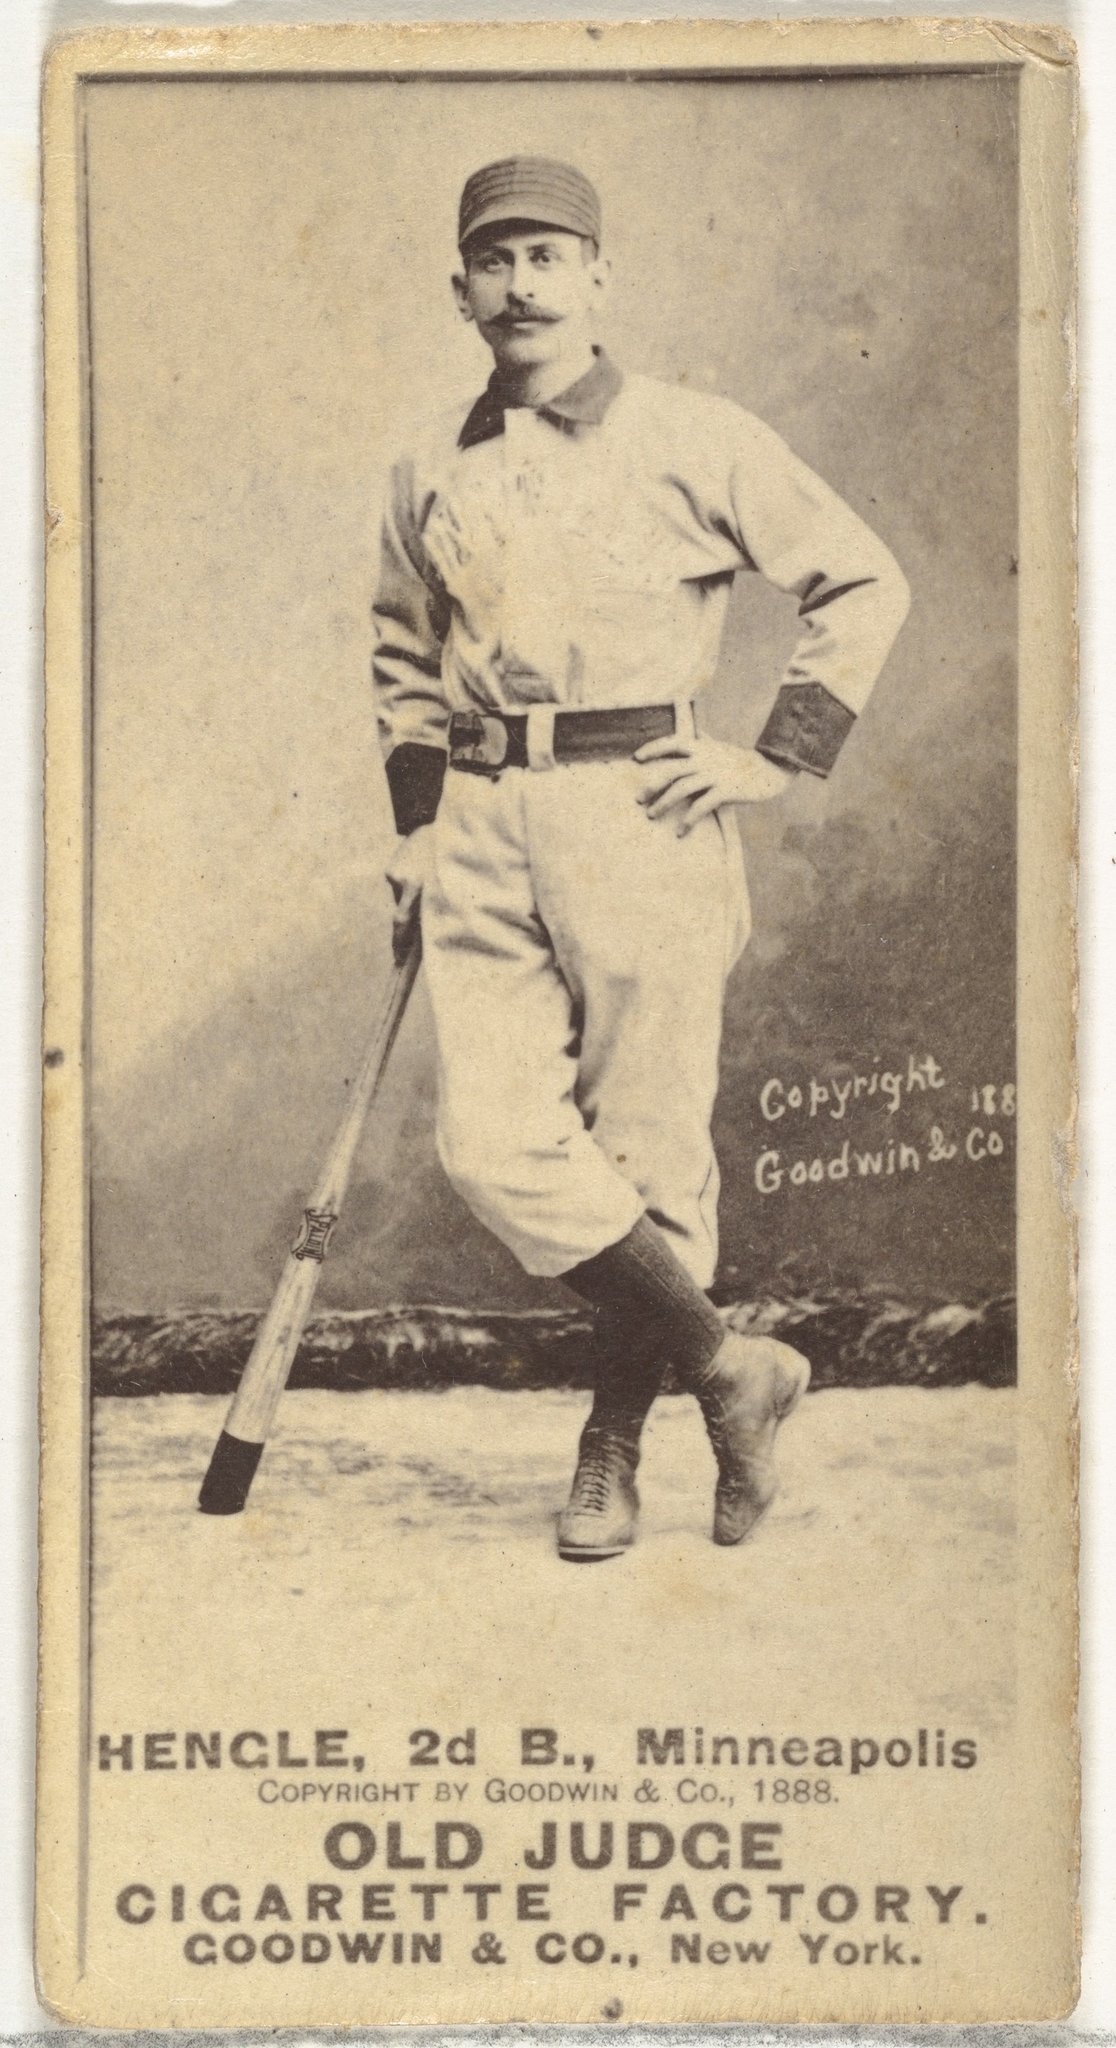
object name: baseball card, photograph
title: Emery J. "Moxie" Hengel, 2nd Base, Minneapolis, from the Old Judge series (N172) for Old Judge Cigarettes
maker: goodwin & company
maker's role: publisher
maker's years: 1850-1950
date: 1888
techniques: albumen silver print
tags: men,portraits,baseball,athletes